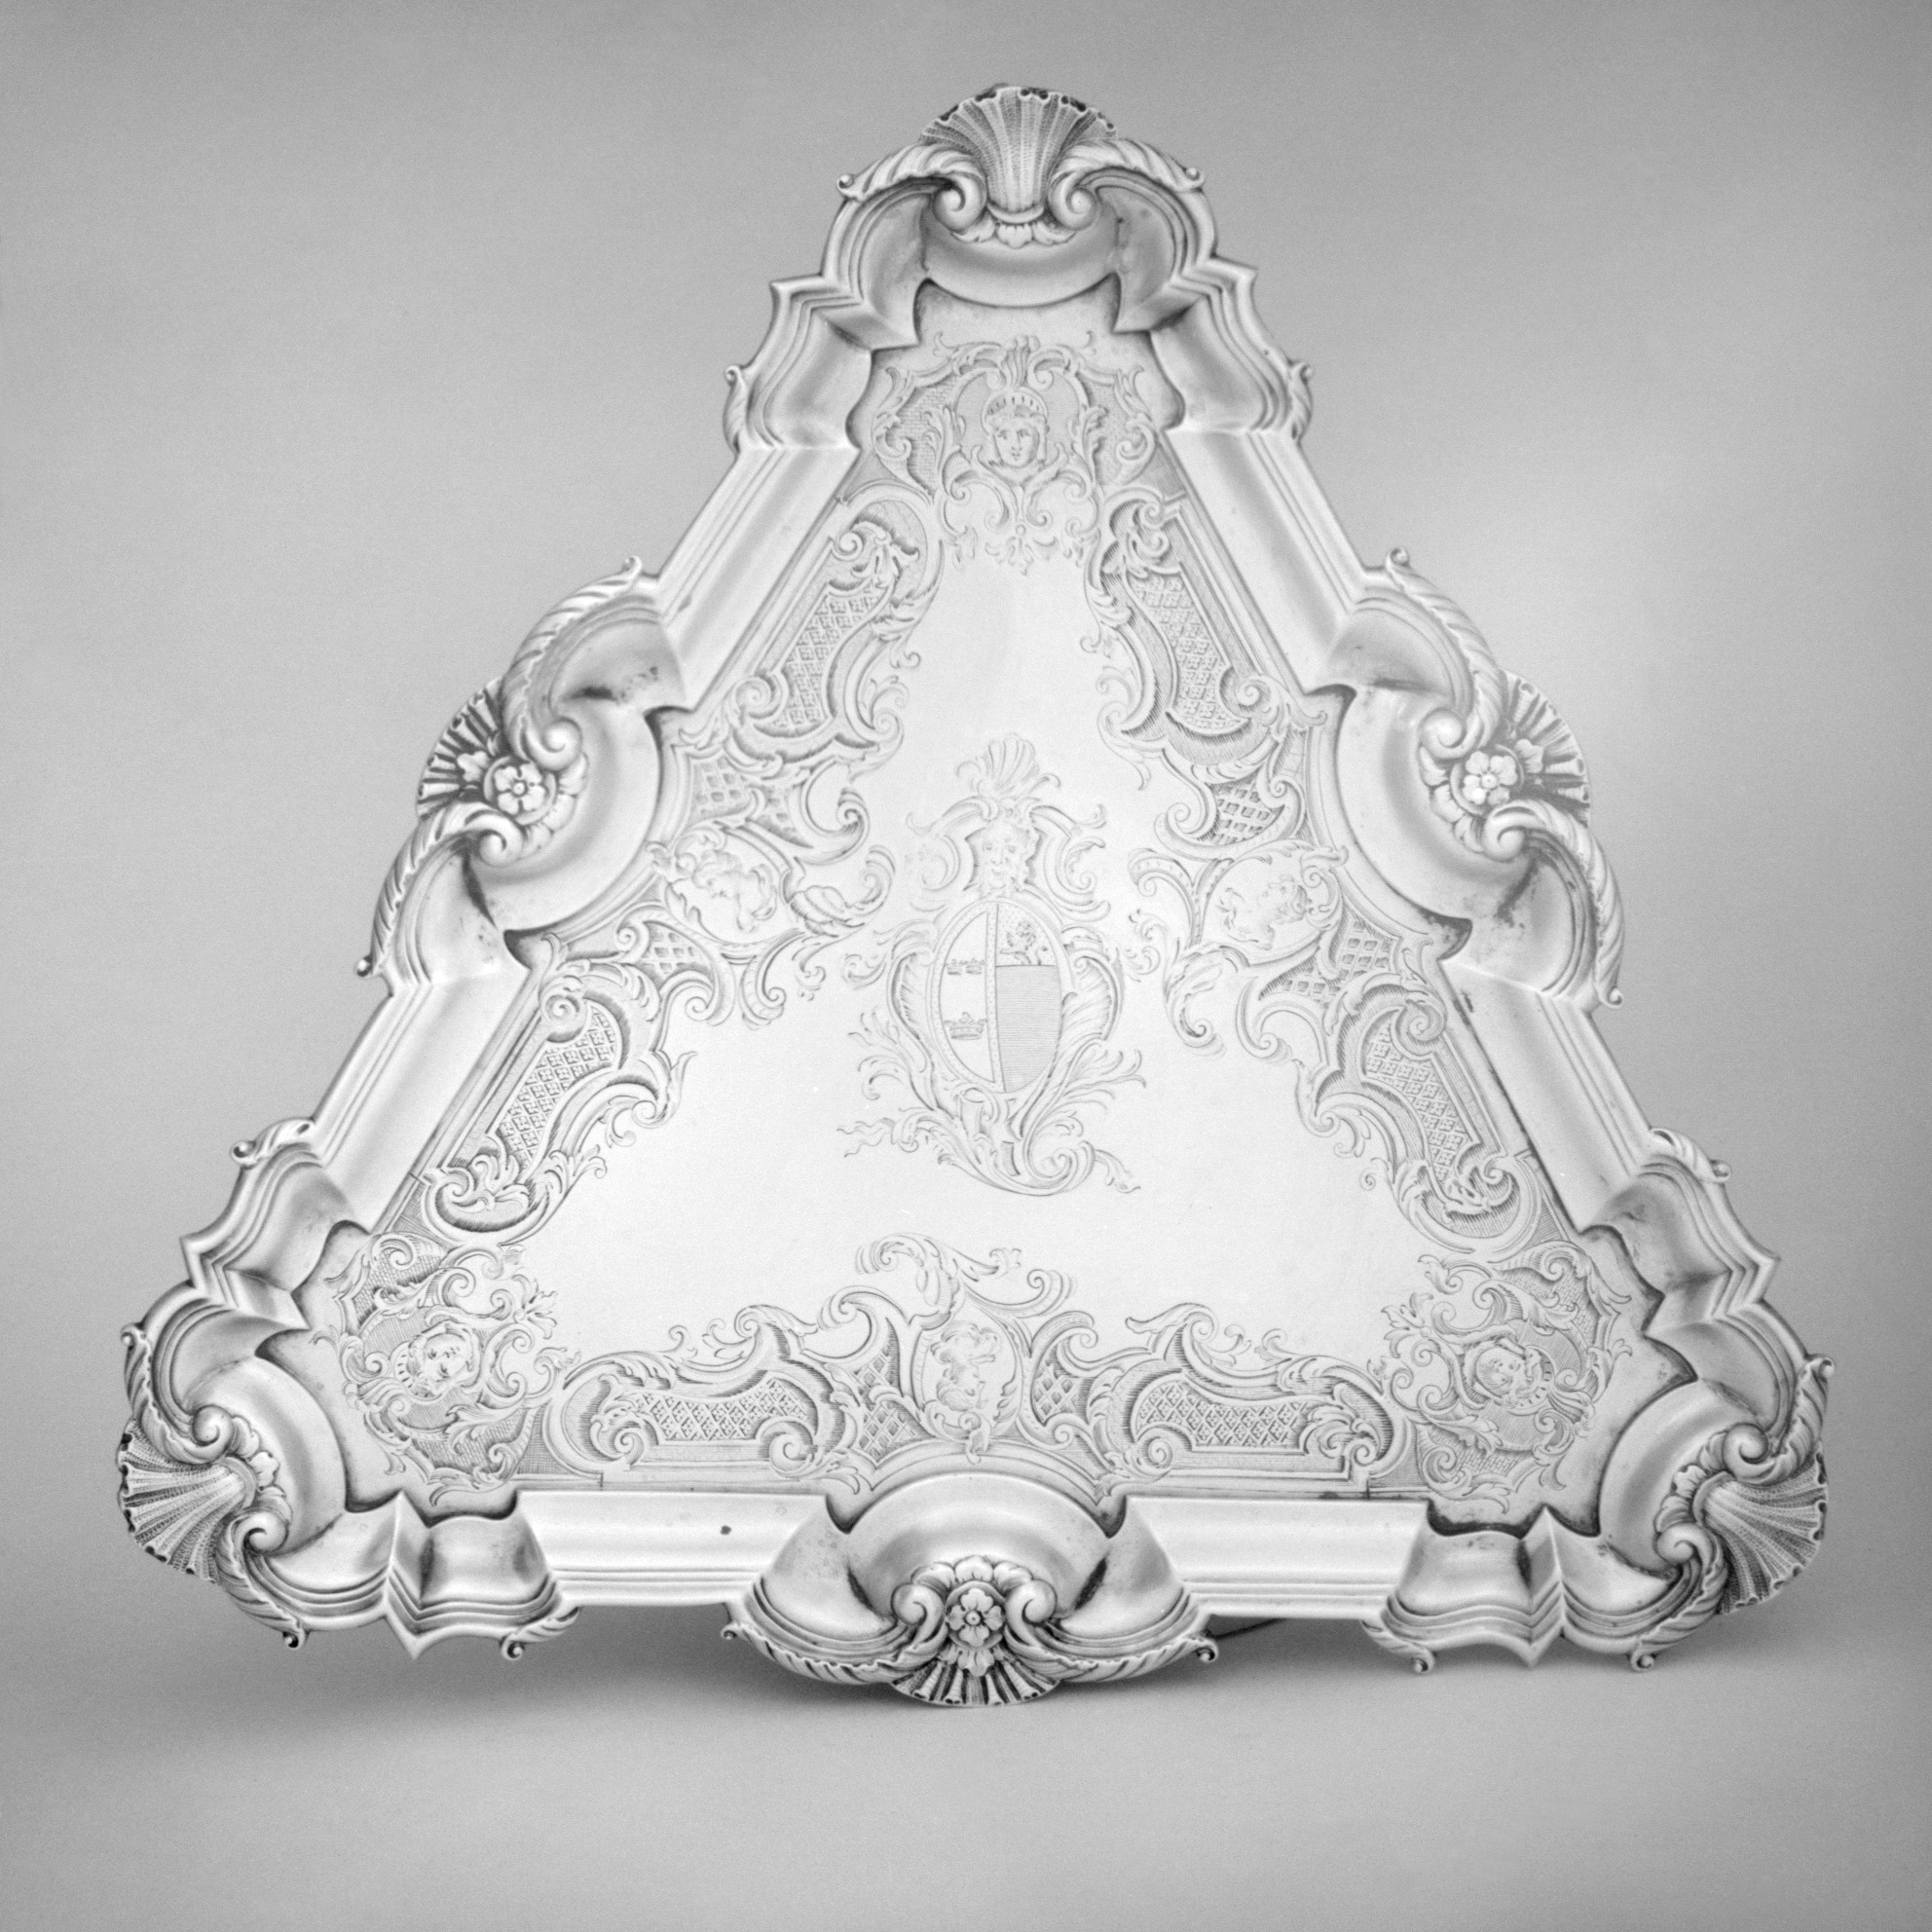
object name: salver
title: Salver for a teakettle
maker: augustin courtauld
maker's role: maker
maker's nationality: british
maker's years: 1685-1751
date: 1735-1736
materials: silver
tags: coat of arms